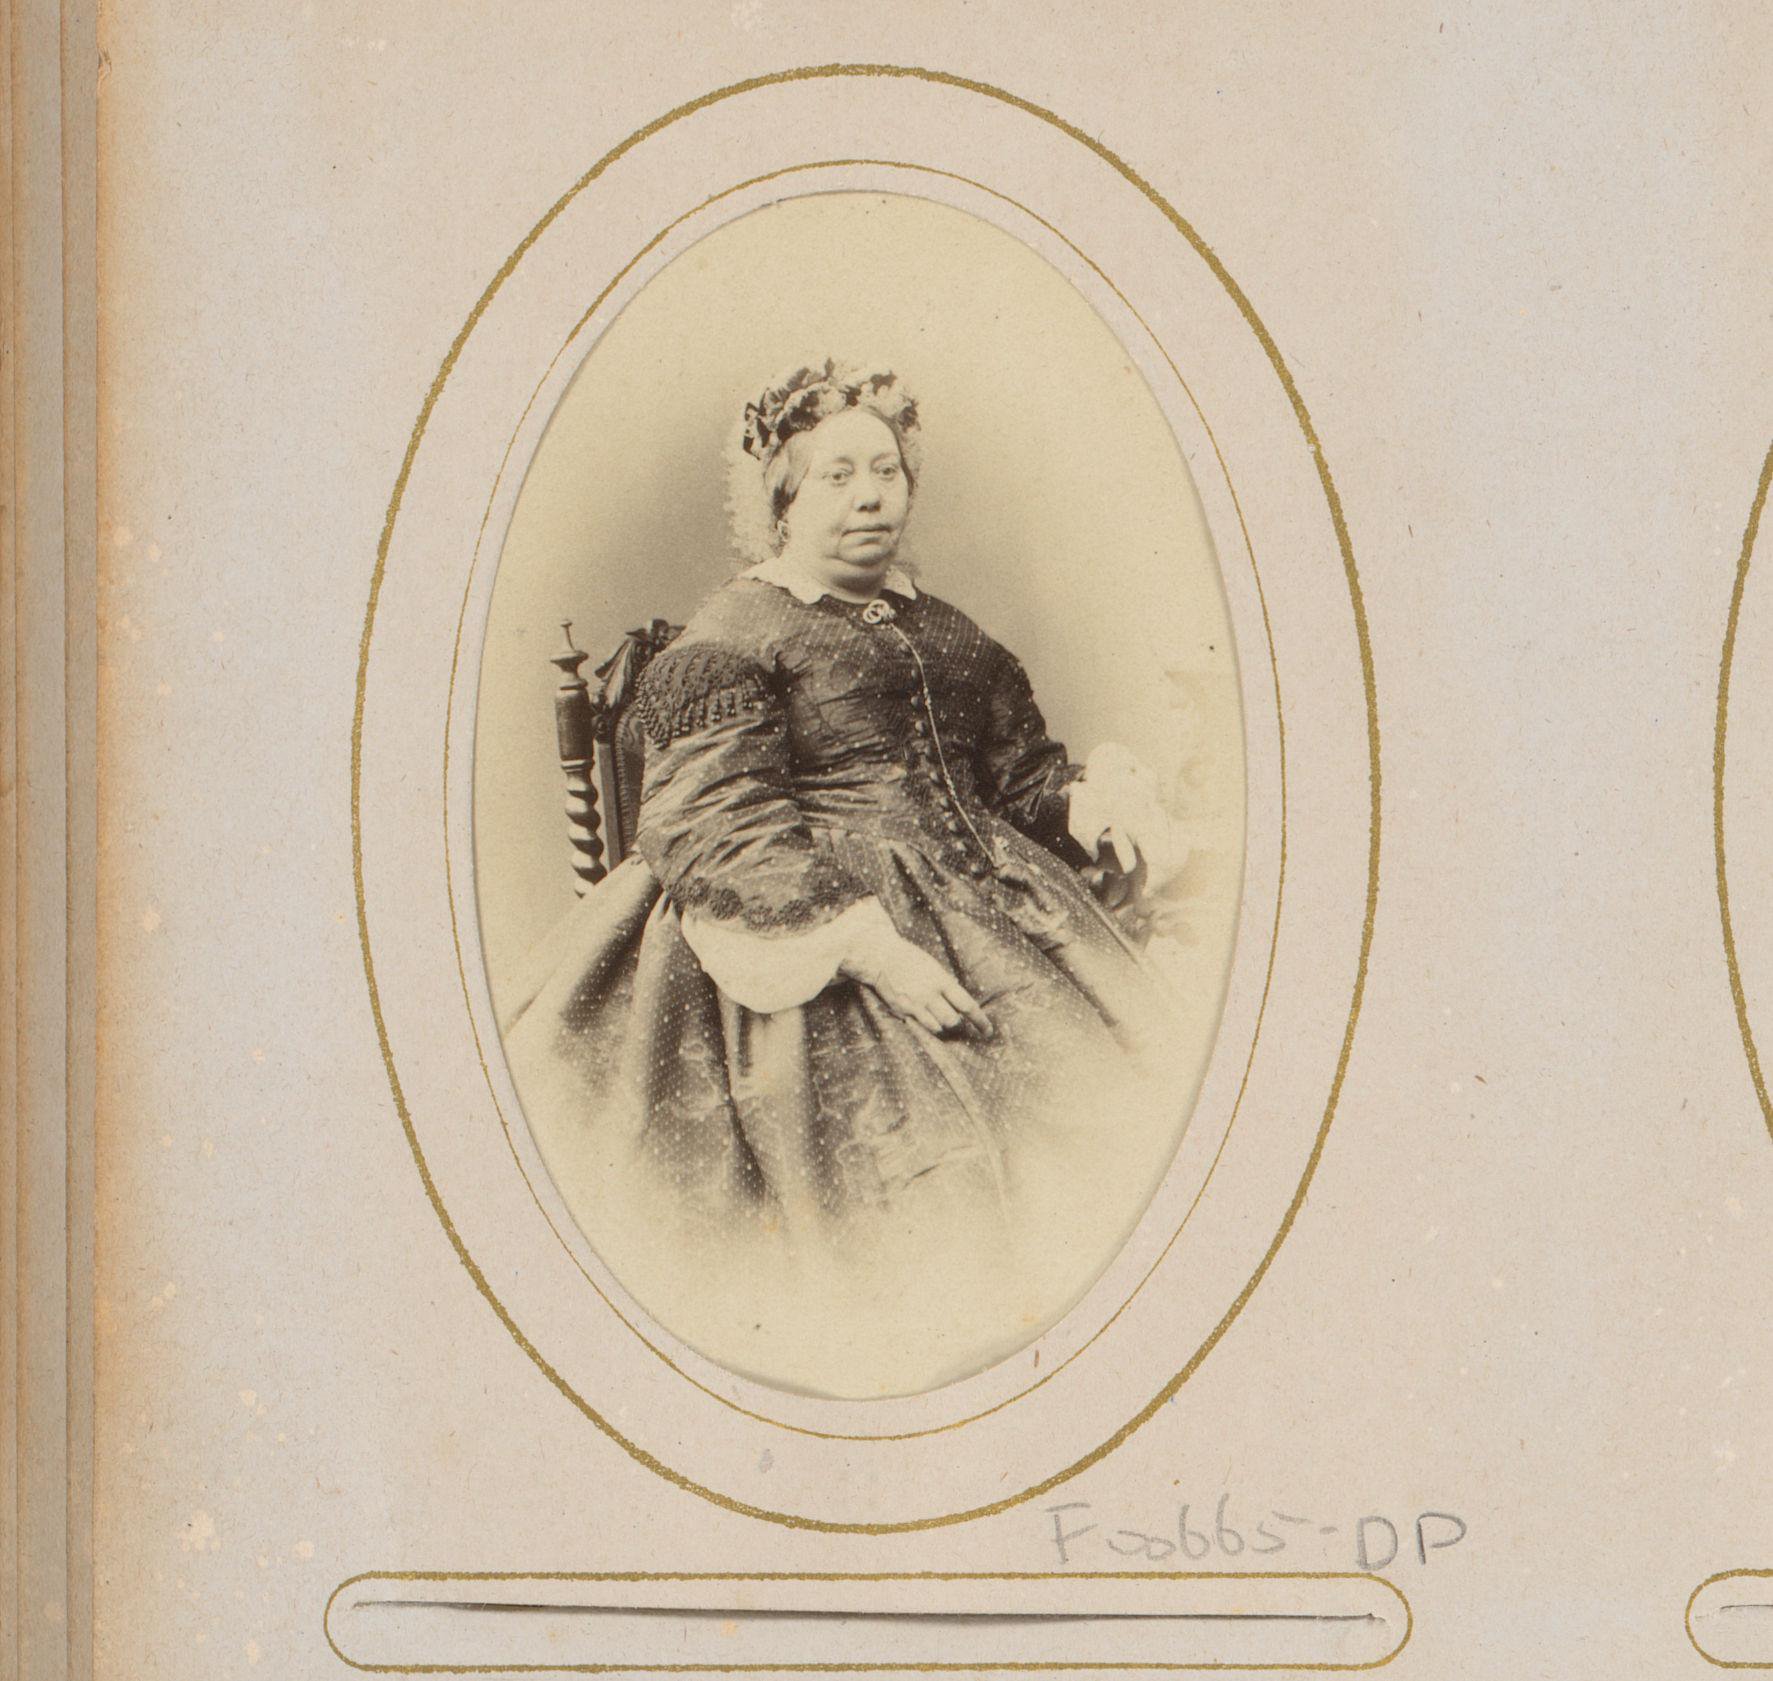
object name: photograph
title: Portret van een vrouw met muts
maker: Anonymous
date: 1855-1880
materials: cardboard, photographic support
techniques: albumen print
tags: historical persons - bb - woman, head-gear: cap